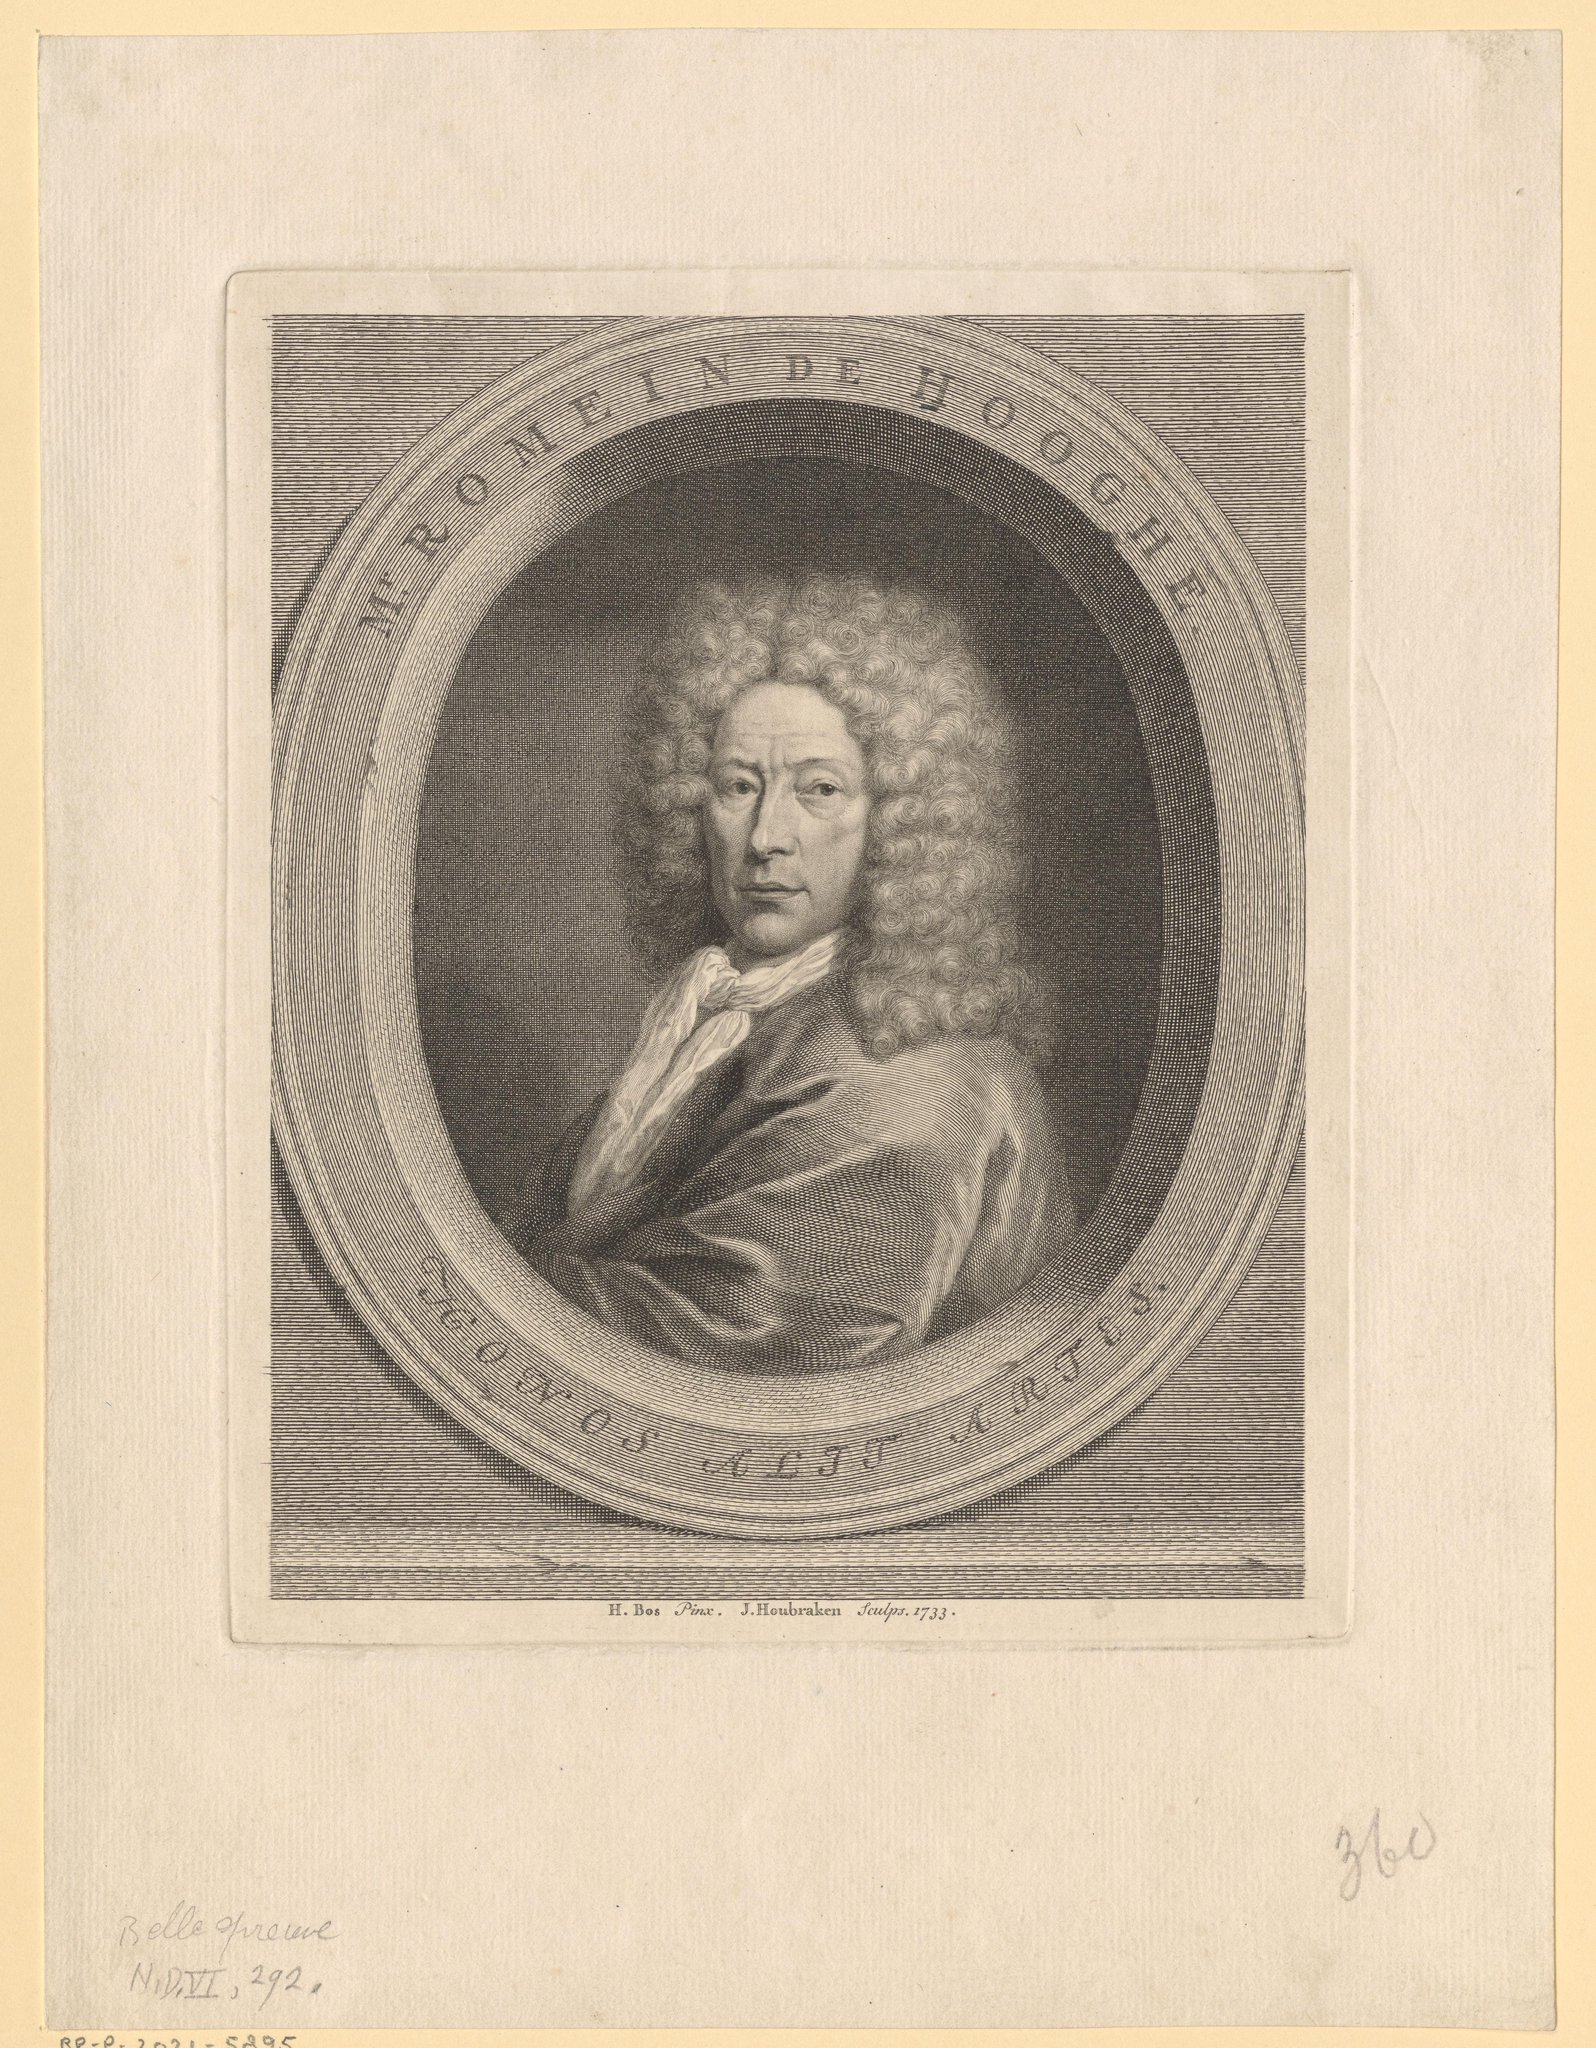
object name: print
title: Portret van Romeyn de Hooghe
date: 1733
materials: paper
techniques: engraving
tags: amsterdam, haarlem, print maker, draughtsman, goldsmith, romeyn de hooghe, historical persons, portrait, self-portrait of graphic artist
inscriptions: date